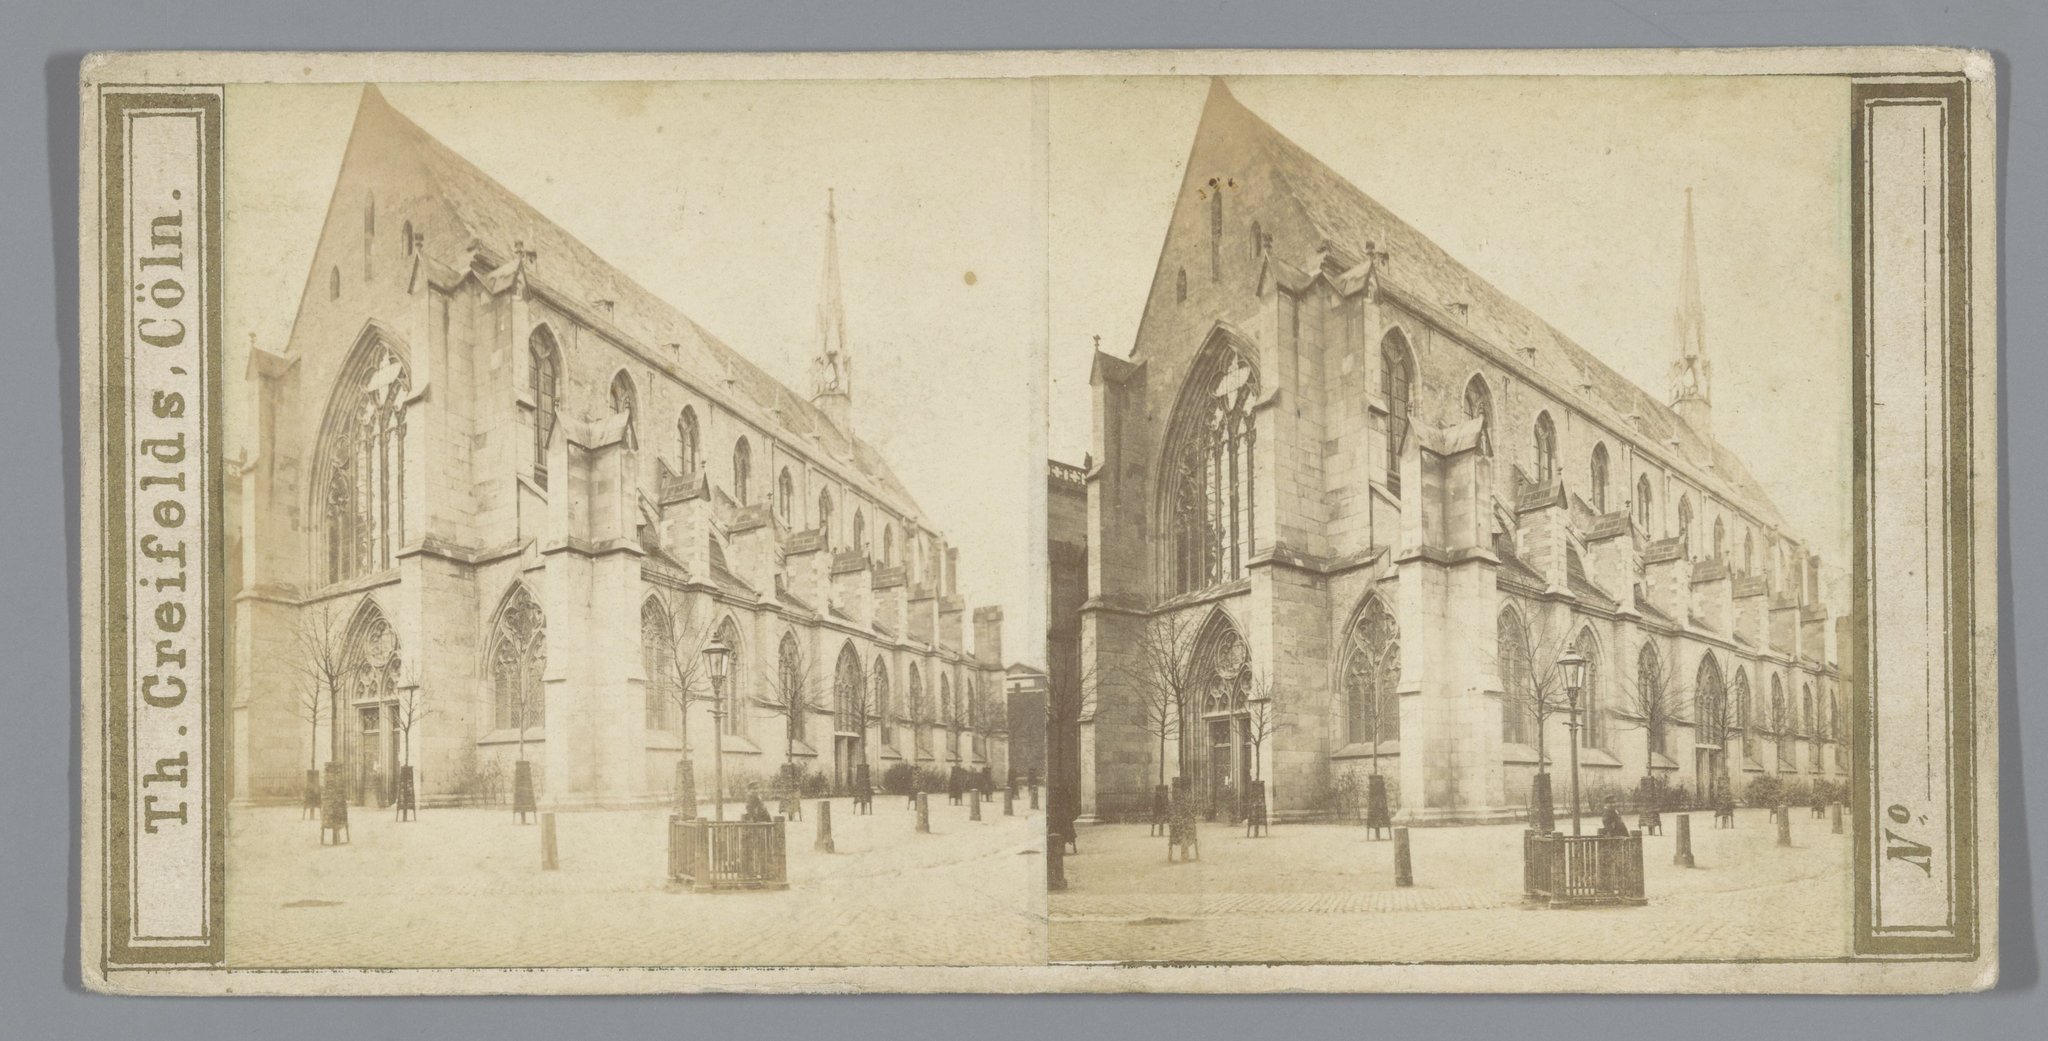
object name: stereograph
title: Minoritenkirche in Keulen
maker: theodor creifelds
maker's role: publisher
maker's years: 1815-1875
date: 1855-1875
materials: cardboard, paper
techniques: albumen print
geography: cologne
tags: church (exterior)